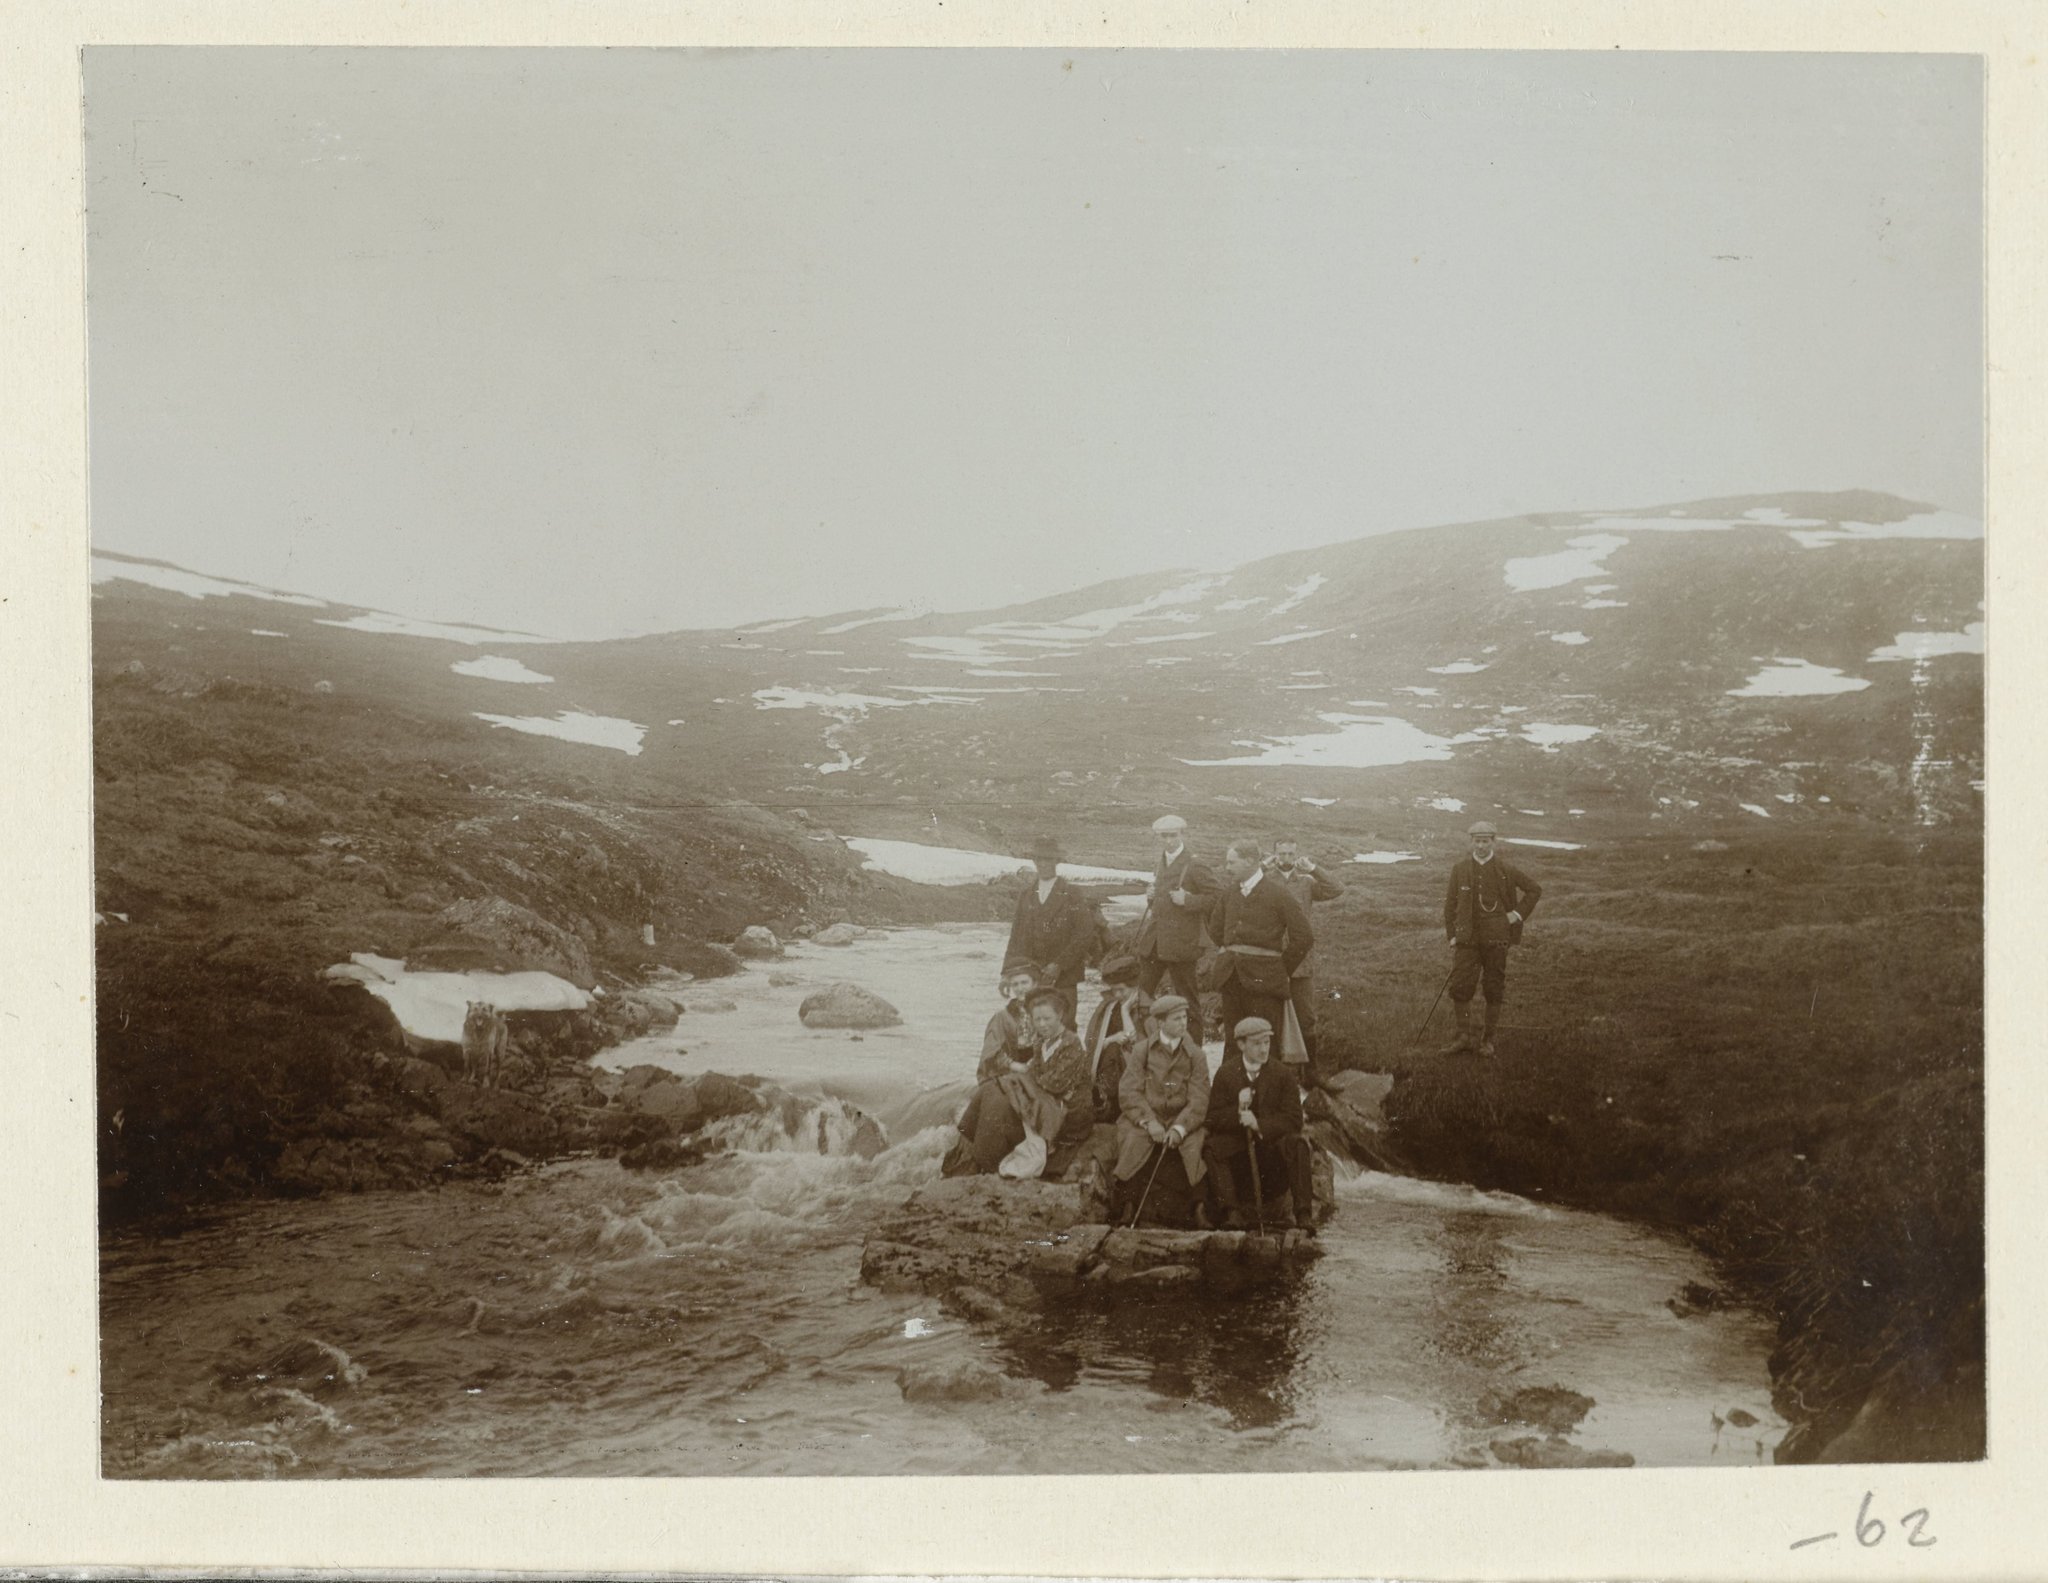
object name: photograph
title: Het gezelschap rust uit op een rots boven een berg in de Harz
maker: geldolph adriaan kessler (dolph)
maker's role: fotograaf, industrieel, voetballer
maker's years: 1884-1945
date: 1903-1908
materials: cardboard, photographic support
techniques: gelatin silver print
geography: harz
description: Het gezelschap rust uit op een rots in een stromende beek in een glooiend, licht besneeuwd landschap, vermoedelijk in de Harz. Onderdeel van het fotoalbum van Dolph Kessler met opnamen die hij maakte tijdens zijn verblijf in Engeland en op een wereldreis die hij als secretaris van Henri Deterding (directeur Koninklijke Olie) ondernam naar Nederlands-Indië, Japan, China en de Verenigde Staten, tussen 1906 en 1908.